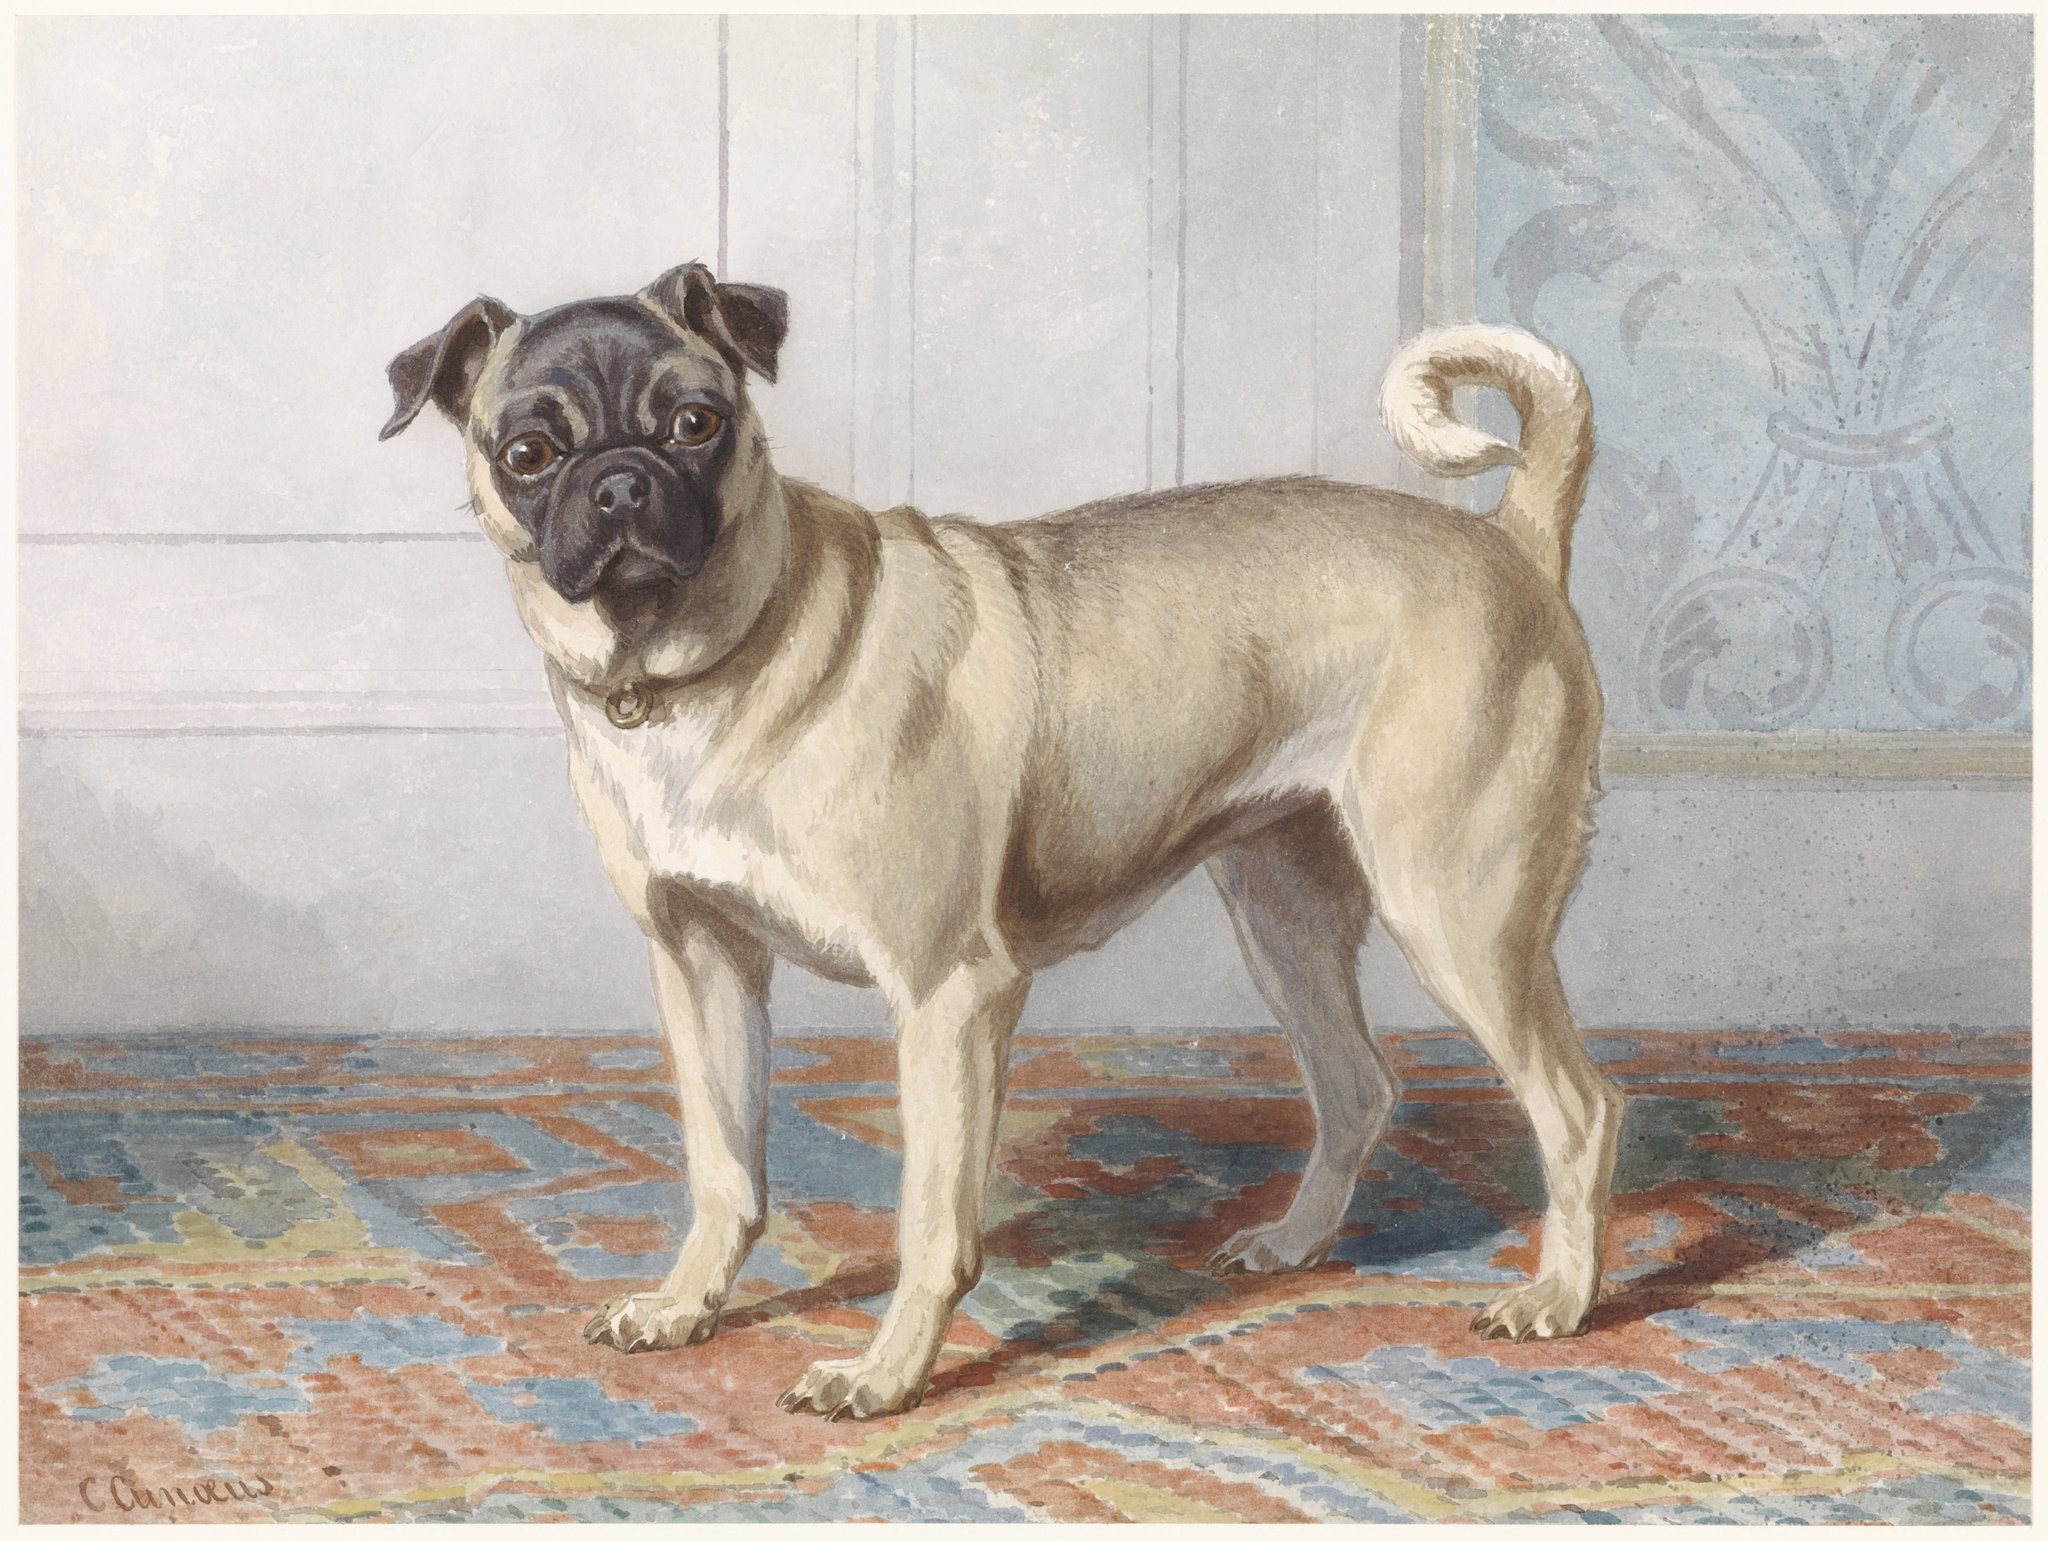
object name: drawing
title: Portrait of Edwin vom Rath’s Pug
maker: conradijn cunaeus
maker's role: draughtsman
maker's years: 1828-1895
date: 1880-1895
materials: paper, pencil, watercolor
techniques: brush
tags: dog (pug)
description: After his parents died, the unmarried and childless Edwin vom Rath stayed on alone in the vast family house on the Herengracht in Amsterdam. His only company was his pug, here portrayed by the dog painter Conradijn Cunaeus. Vom Rath used the fortune his family had amassed in trading and processing cane sugar to buy art and to support a variety of cultural institutions.